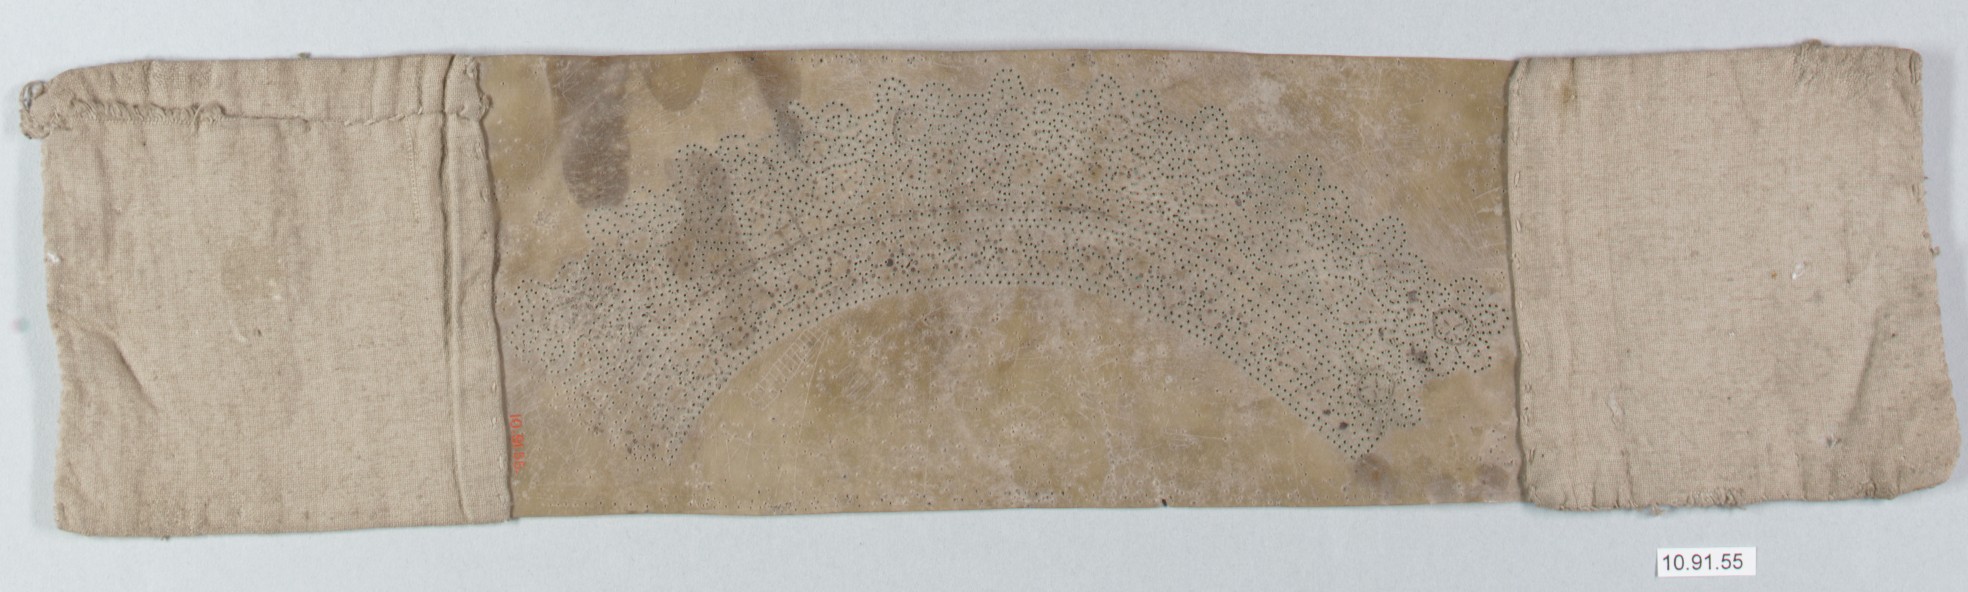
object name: pricking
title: Prickings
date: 1701-1900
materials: parchment